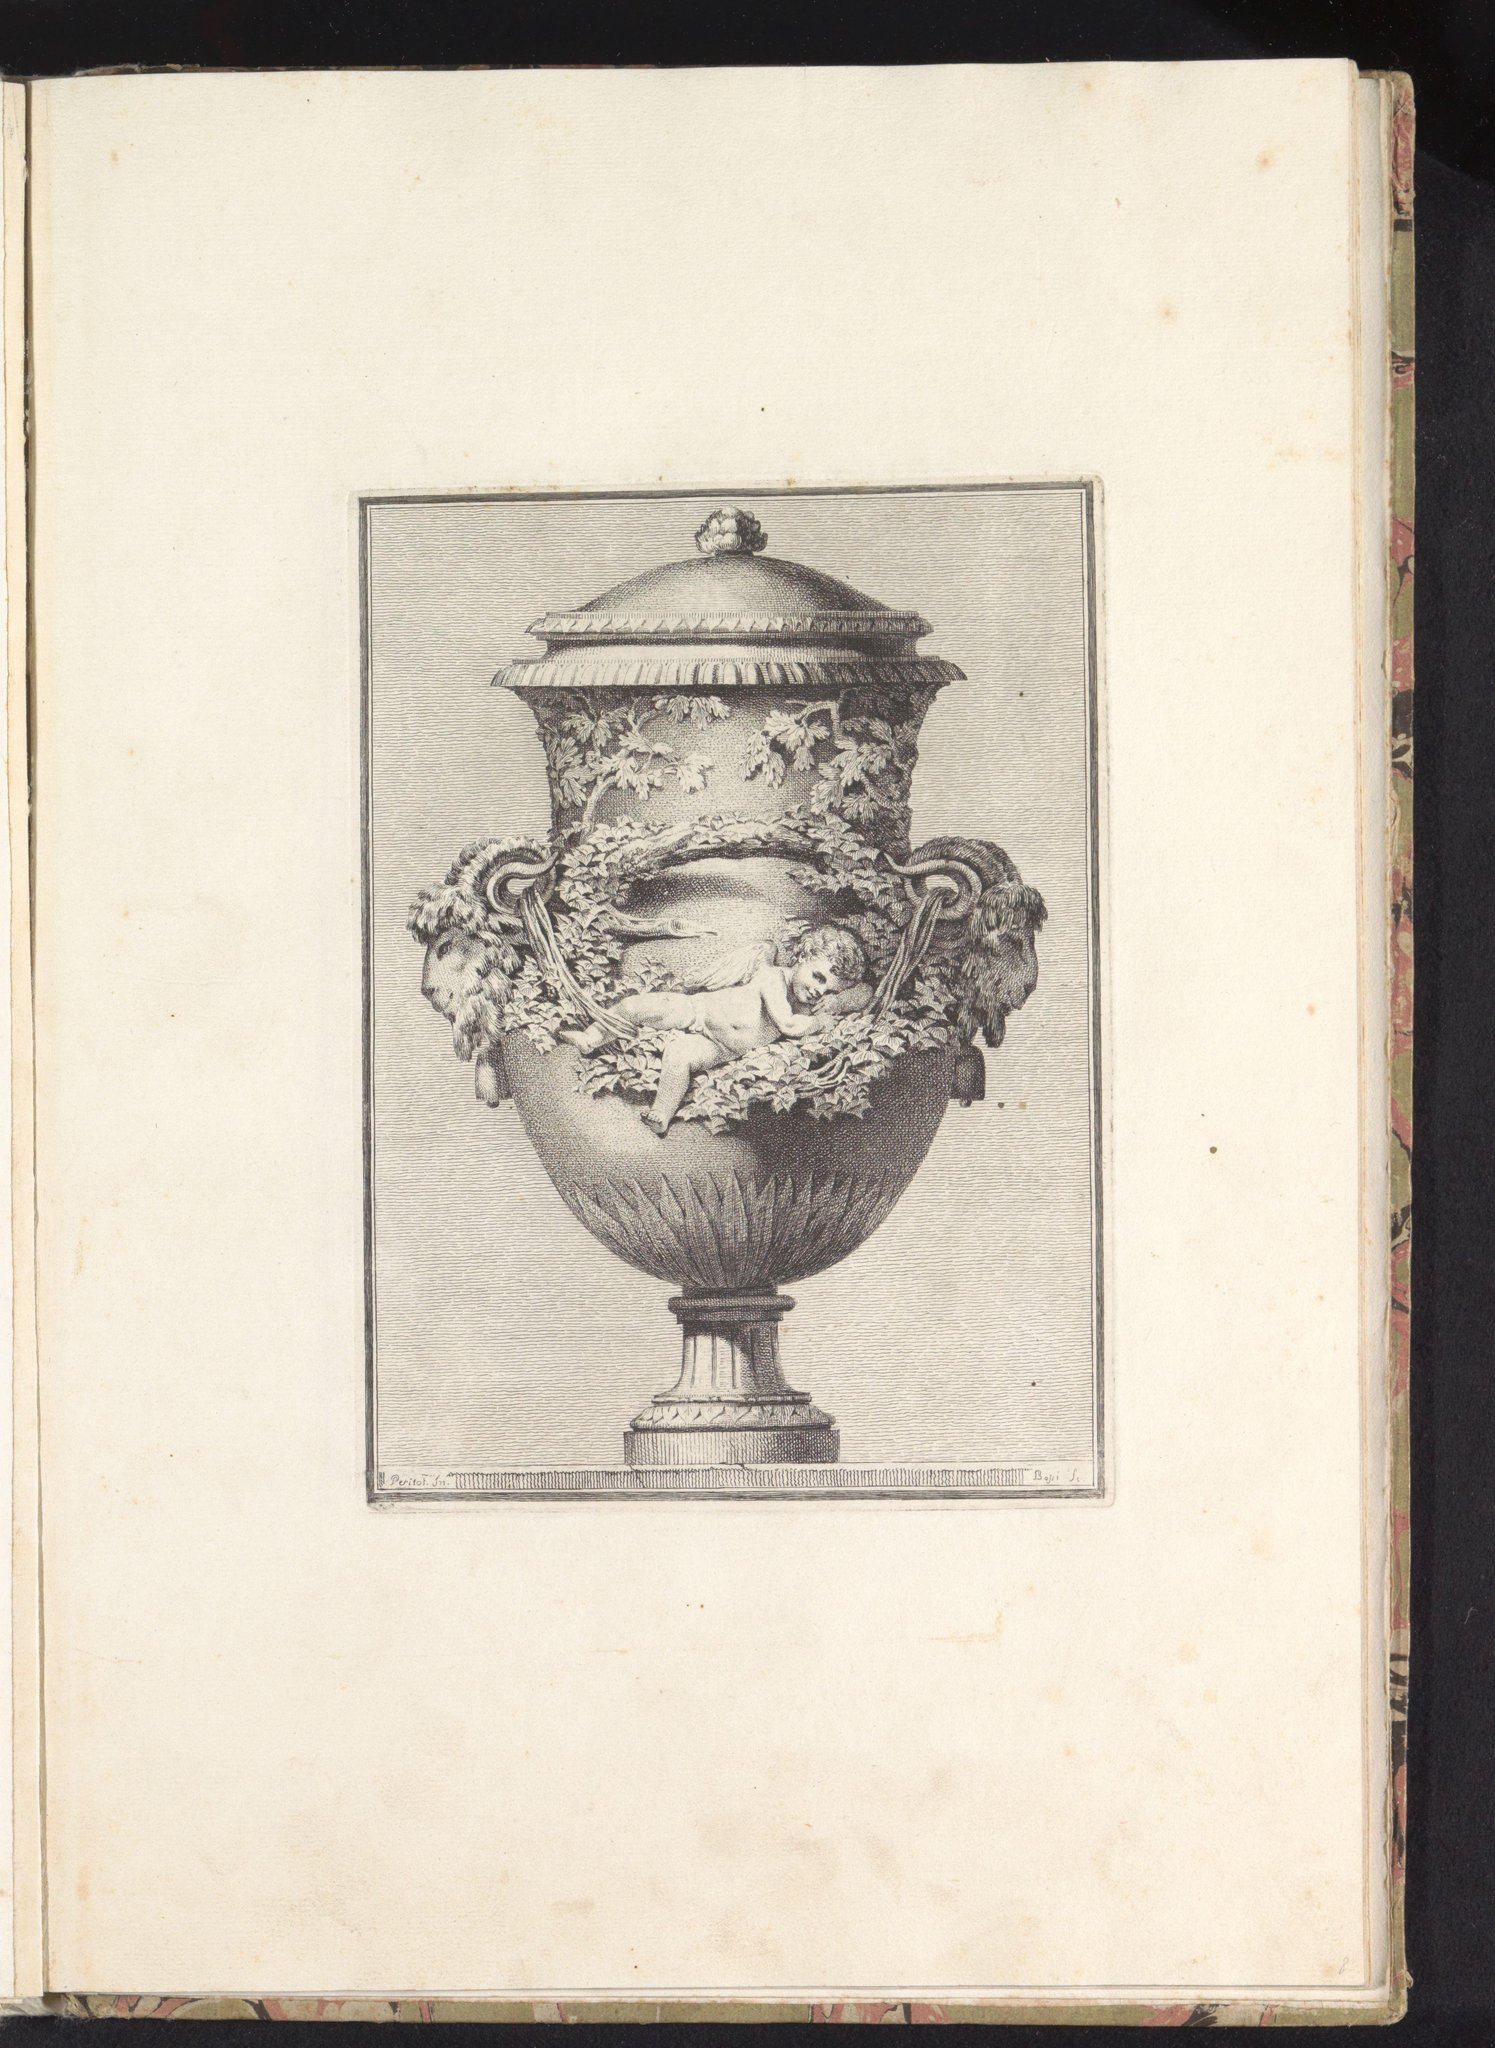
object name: ornament print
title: Suite des Vases tirée du Cabinet de Son Excellence Monsieur Du Tillot...Parme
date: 1764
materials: paper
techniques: etching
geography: parma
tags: ram's head ~ ornament, vase ~ ornament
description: Grote vaas, staande op een muur, afgesloten door een deksel. De vaas is gedecoreerd met acanthusbladeren, een liggende putto en twee ramskoppen. No. 9 uit serie van 31. Prent maakt deel uit van een album. Gedrukt recto rechtsboven: 9.